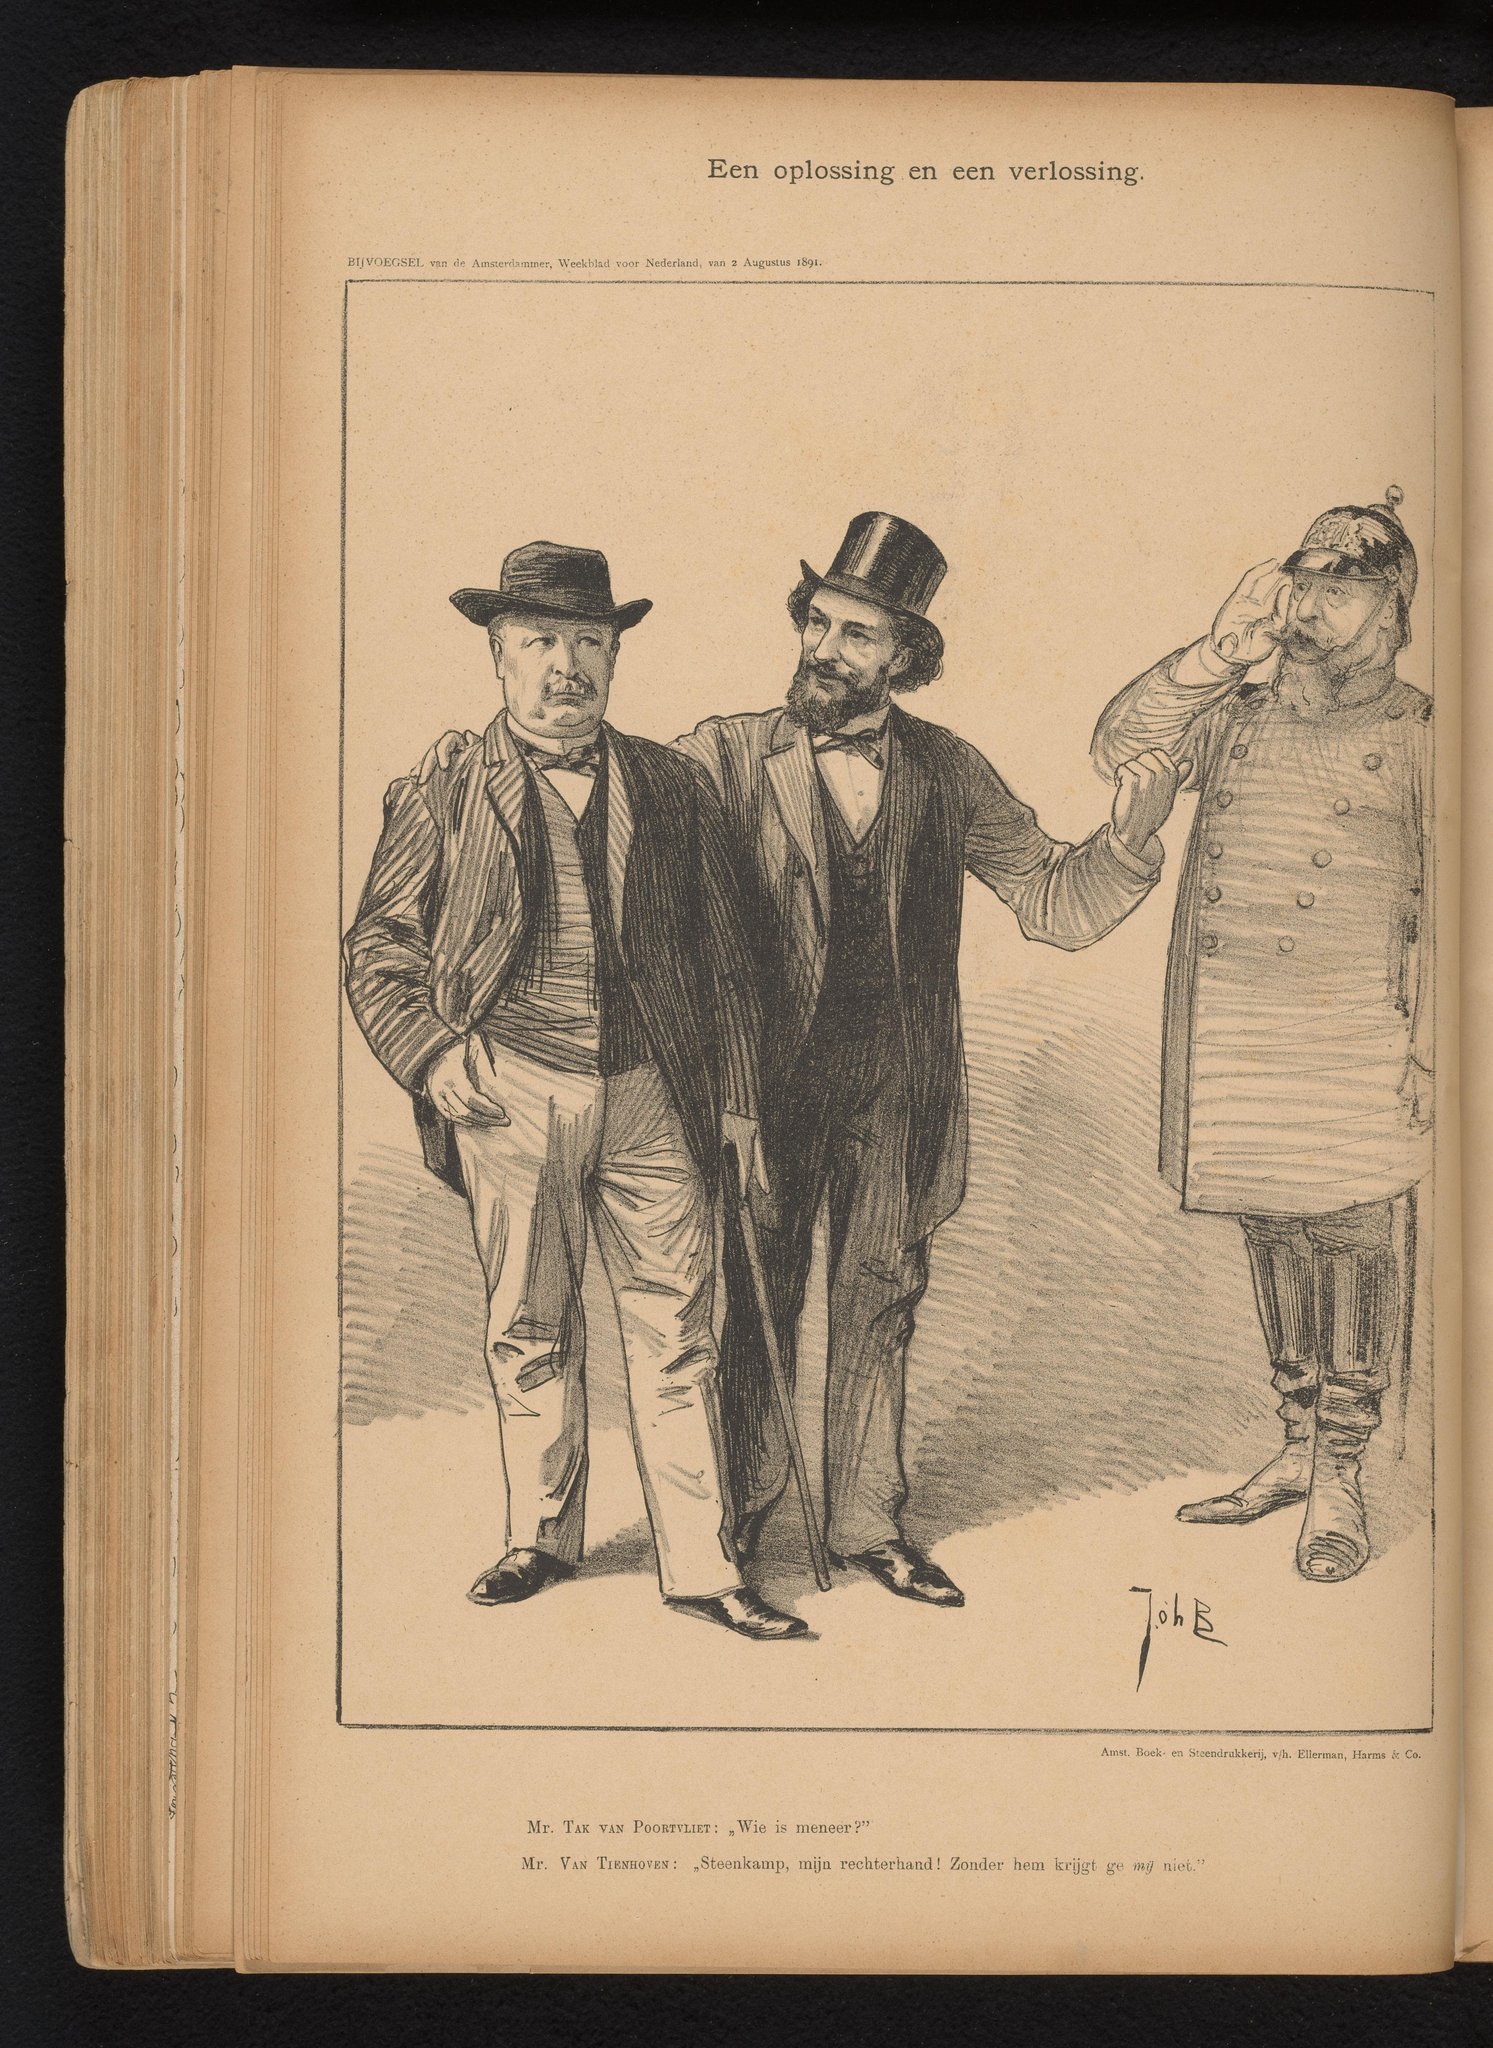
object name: cartoon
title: Een oplossing en een verlossing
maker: johan braakensiek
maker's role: draughtsman, print maker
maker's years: 1858-1940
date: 1891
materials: paper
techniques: lithograph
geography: amsterdam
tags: mayor, gijsbert van tienhoven, the hague, minister ~ government, political caricatures and satires, police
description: Gijsbert van Tienhoven stelt Tak van Poortvliet voor aan zijn rechterhand P.W. Steenkamp, hoofdcommissaris van de politie te Amsterdam.